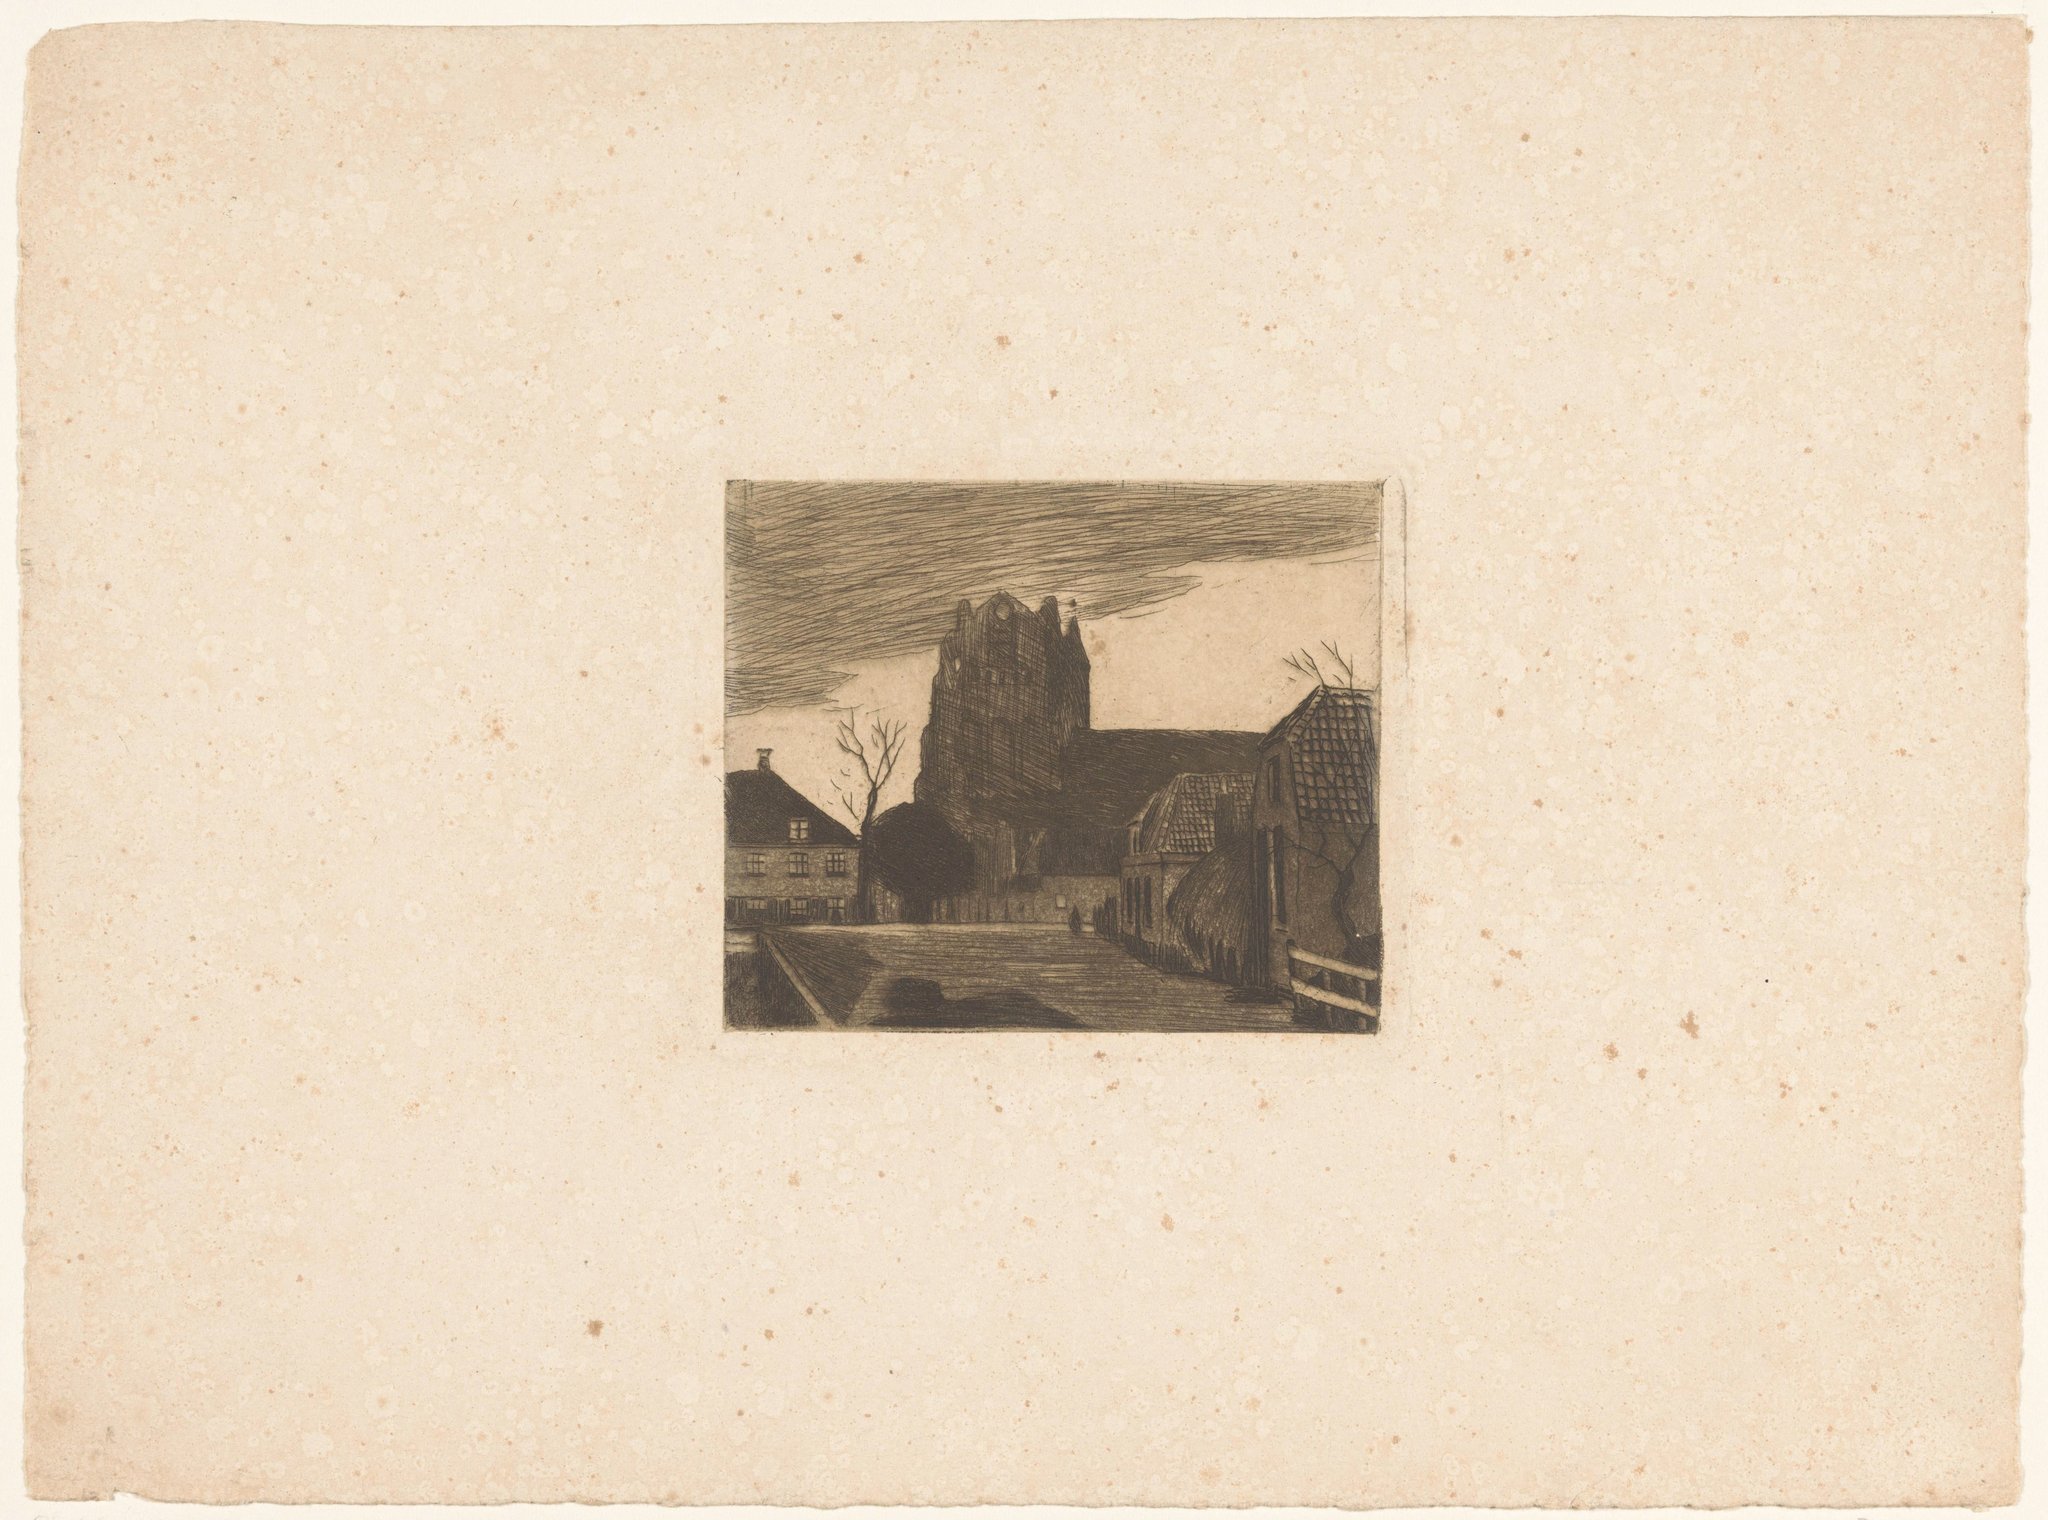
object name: print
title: Gezicht op de Grote Kerk in Wijk bij Duurstede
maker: willem witsen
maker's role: draughtsman, painter, print maker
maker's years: 1860-1923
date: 1906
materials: paper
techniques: aquatint, etching, intaglio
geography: wijk bij duurstede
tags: village street, housing, building of church, wijk bij duurstede